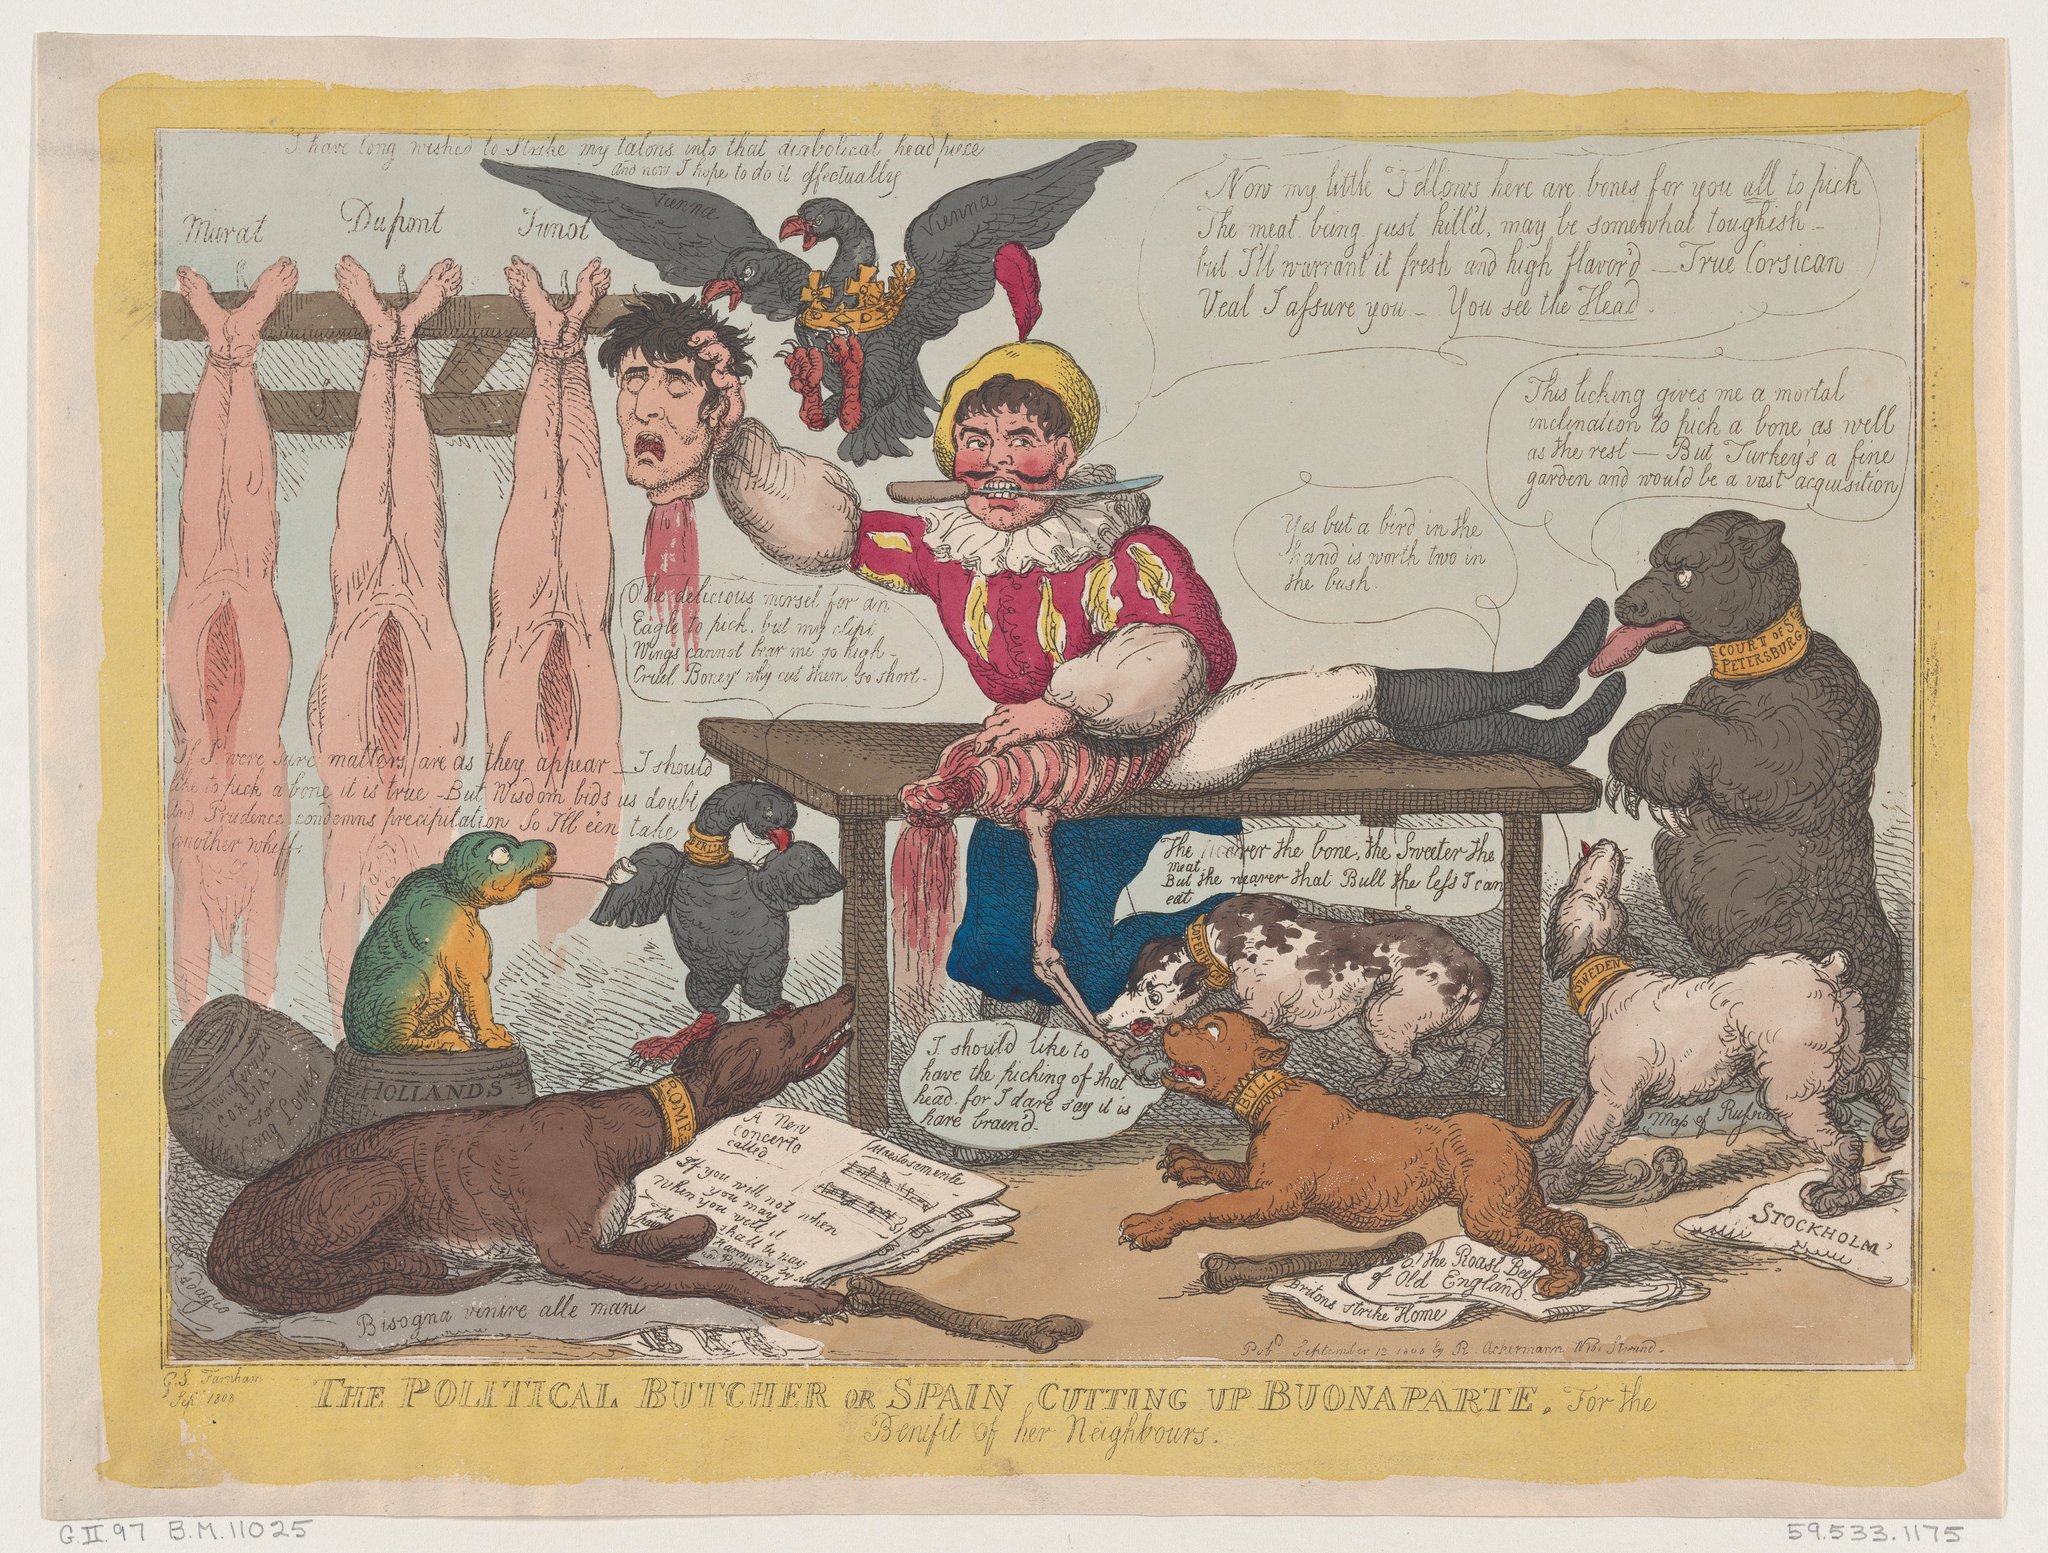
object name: print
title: The Political Butcher, or Spain Cutting Up Buonaparte For The Benefit Of Her Neighbours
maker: thomas rowlandson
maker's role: artist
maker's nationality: british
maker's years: 1757-1827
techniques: etching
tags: bears,eagles,satire,napoleon i,men,dogs,butchers,politics